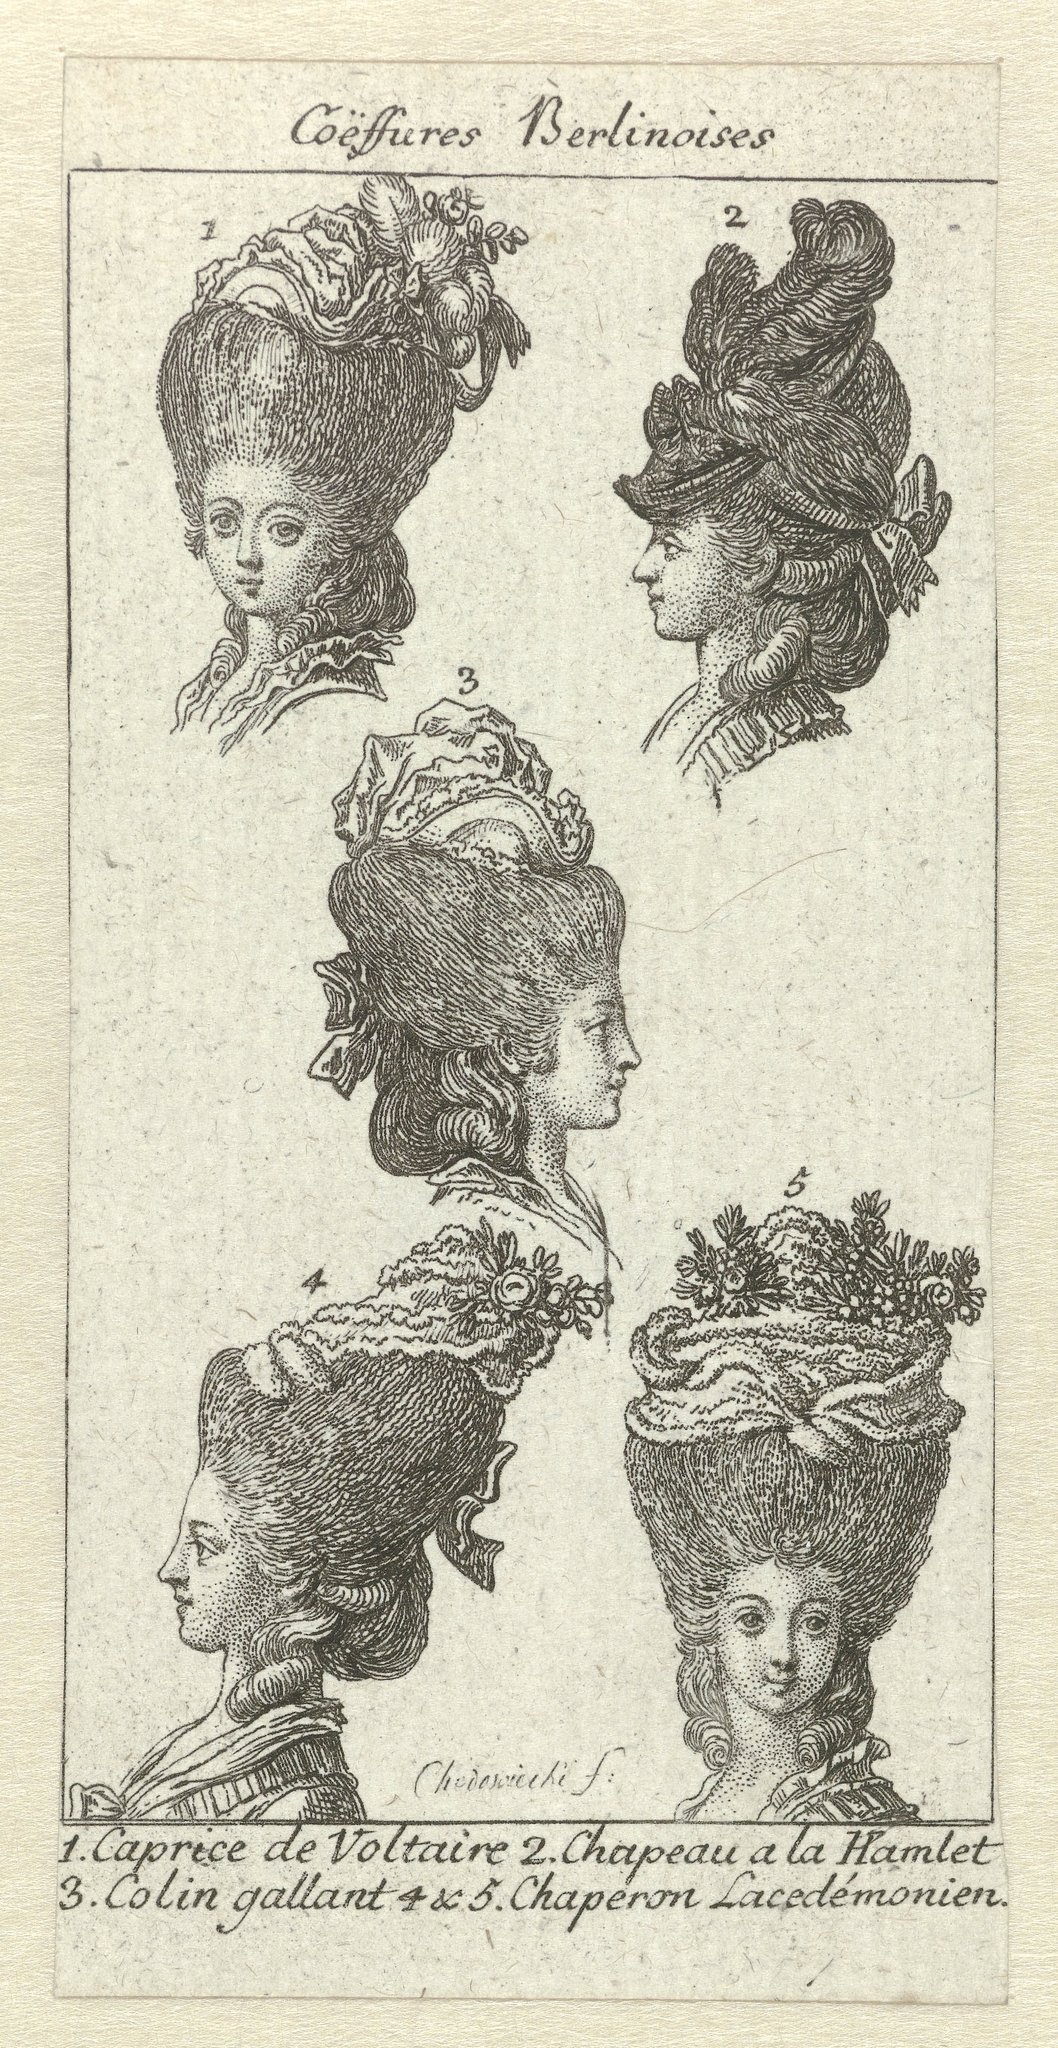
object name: almanac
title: Lauenbergers Genealogischen Kalendar für 1780: Coëffures Berlinoises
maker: daniel nikolaus chodowiecki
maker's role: draughtsman, print maker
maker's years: 1726-1801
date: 1779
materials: paper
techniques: etching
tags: calendar, almanac, styles of hairdress - aa - ~ women, fashion plates, head-gear: hat (+ women's clothes)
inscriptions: caption: ‘1. Caprice de Voltaire 2. Chapeau a la Hamlet 3. Colin gallant 4&5. Chaperon Lacedémonien.’, title: ‘Coëffures Berlinoises’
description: Vijf dameskapsels met hoofddeksels uit Berlijn, in één kader, genummerd één tot en met vijf: 1. Caprice de Voltaire 2. Chapeau a la Hamlet 3. Colin gallant 4&5. Chaperon Lacedémonien. De prent maakt deel uit van de almanak Lauenbergers Genealogischen Kalendar für 1780.